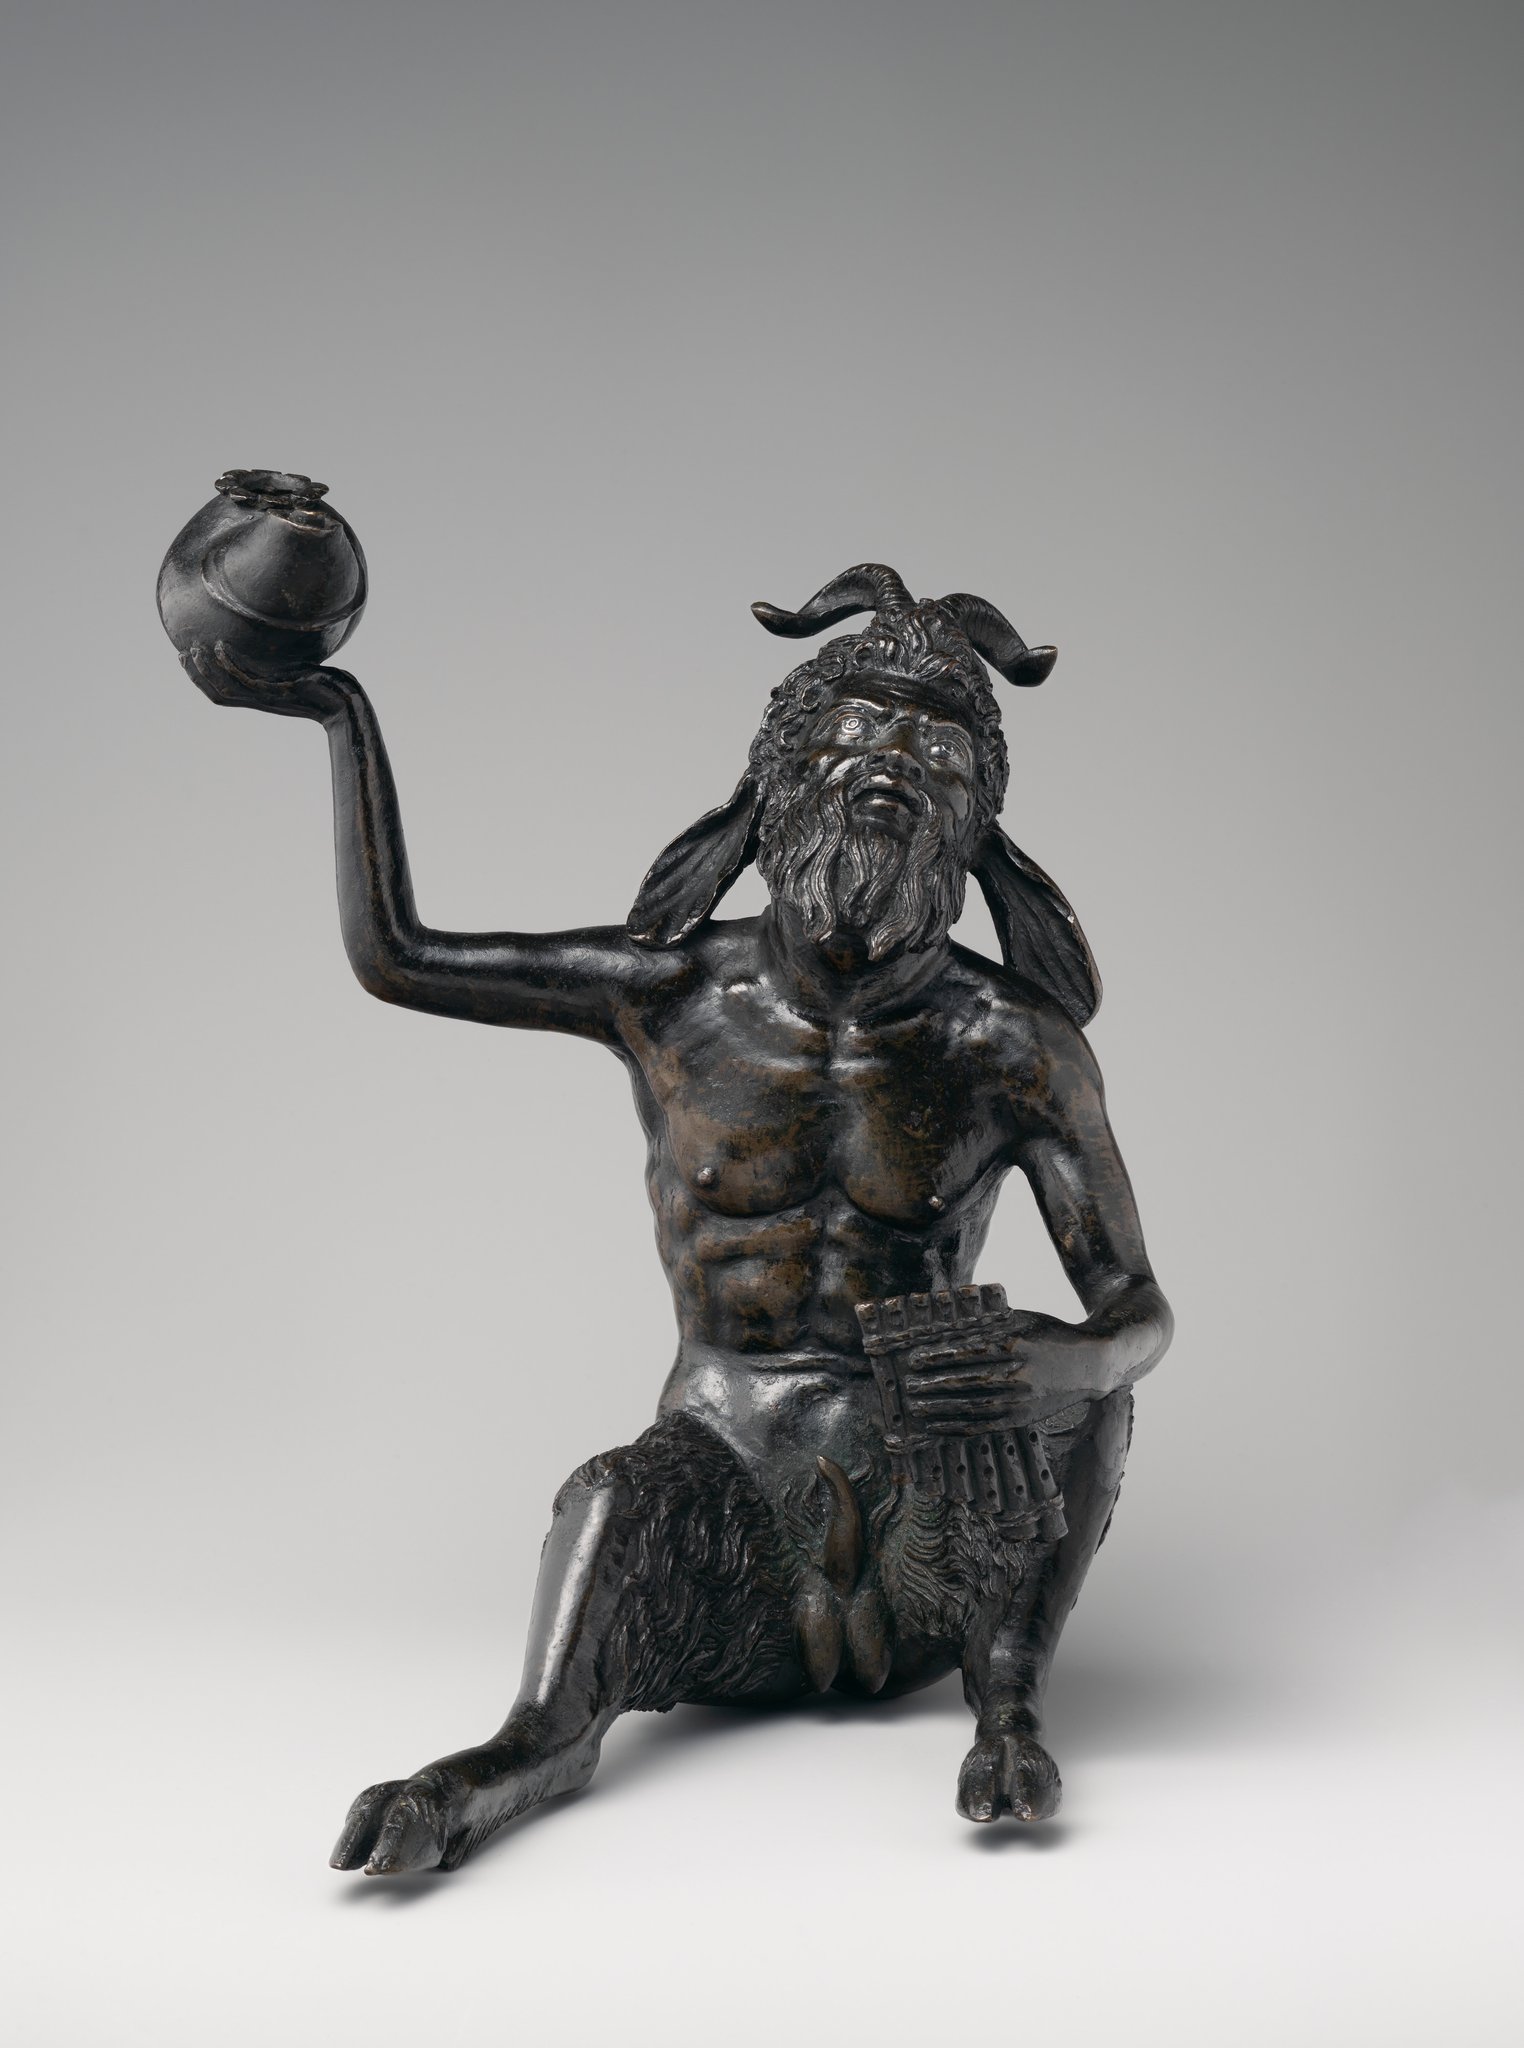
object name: statuette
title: Seated satyr with silvered eyes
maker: andrea briosco, called riccio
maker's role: artist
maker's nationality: italian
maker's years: 1470-1532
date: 1526-1550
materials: bronze, silver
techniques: inlay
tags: satyrs